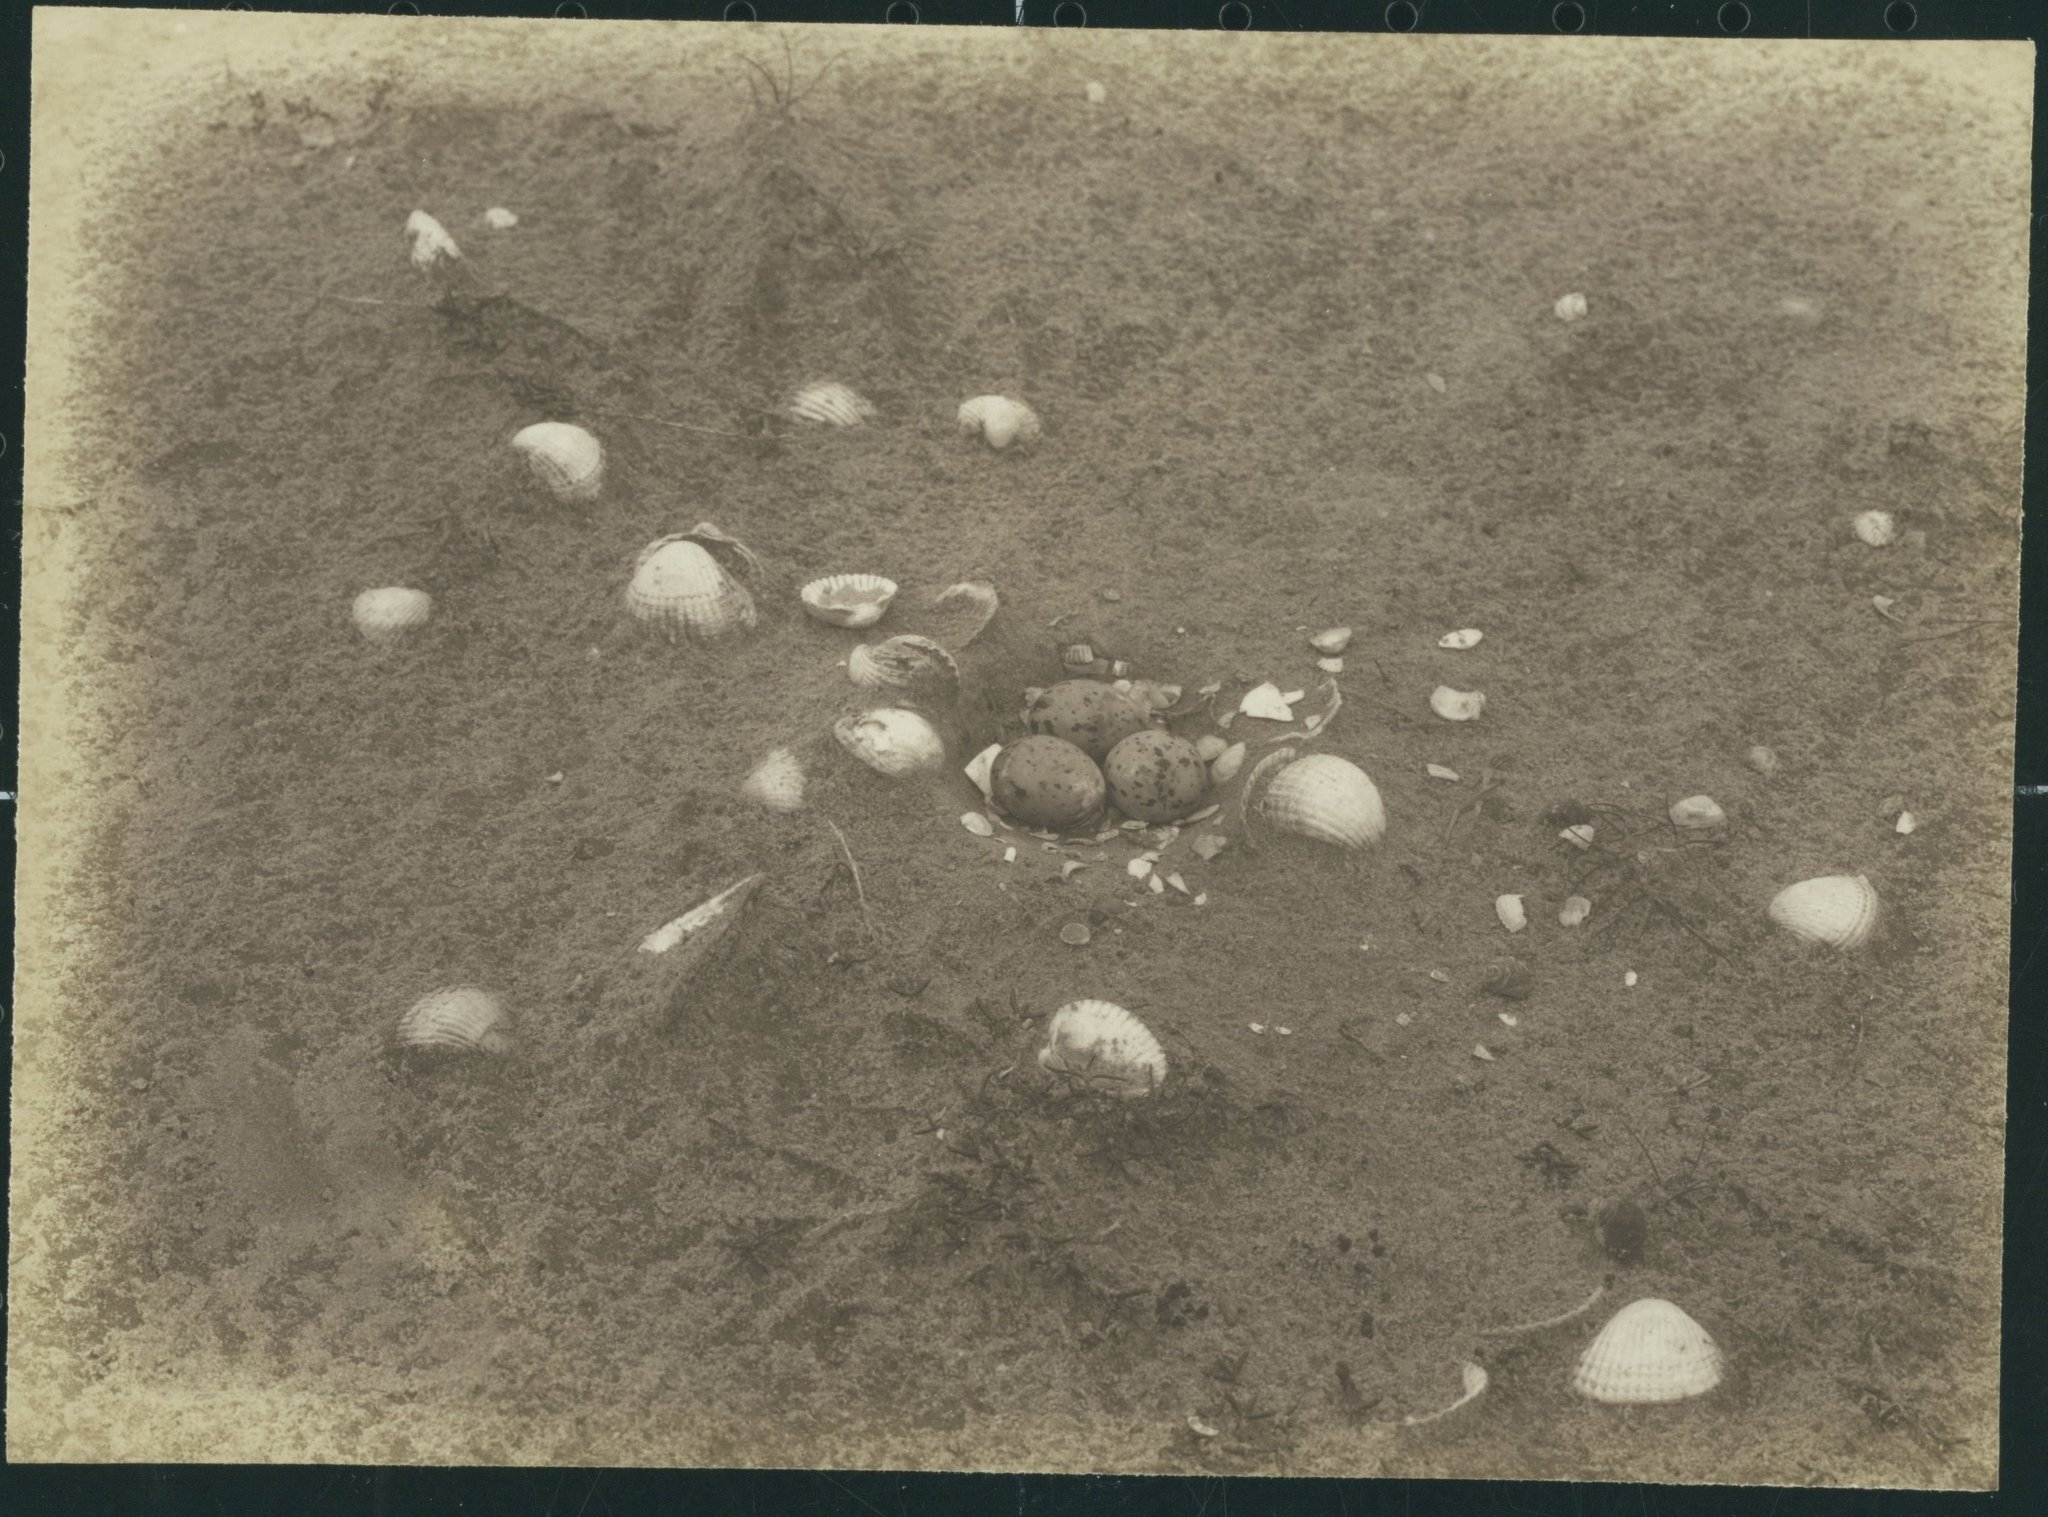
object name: photograph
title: Schelpen en nest in het zand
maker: richard tepe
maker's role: fotograaf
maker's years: 1864-1952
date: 1900-1930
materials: photographic support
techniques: gelatin silver print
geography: netherlands